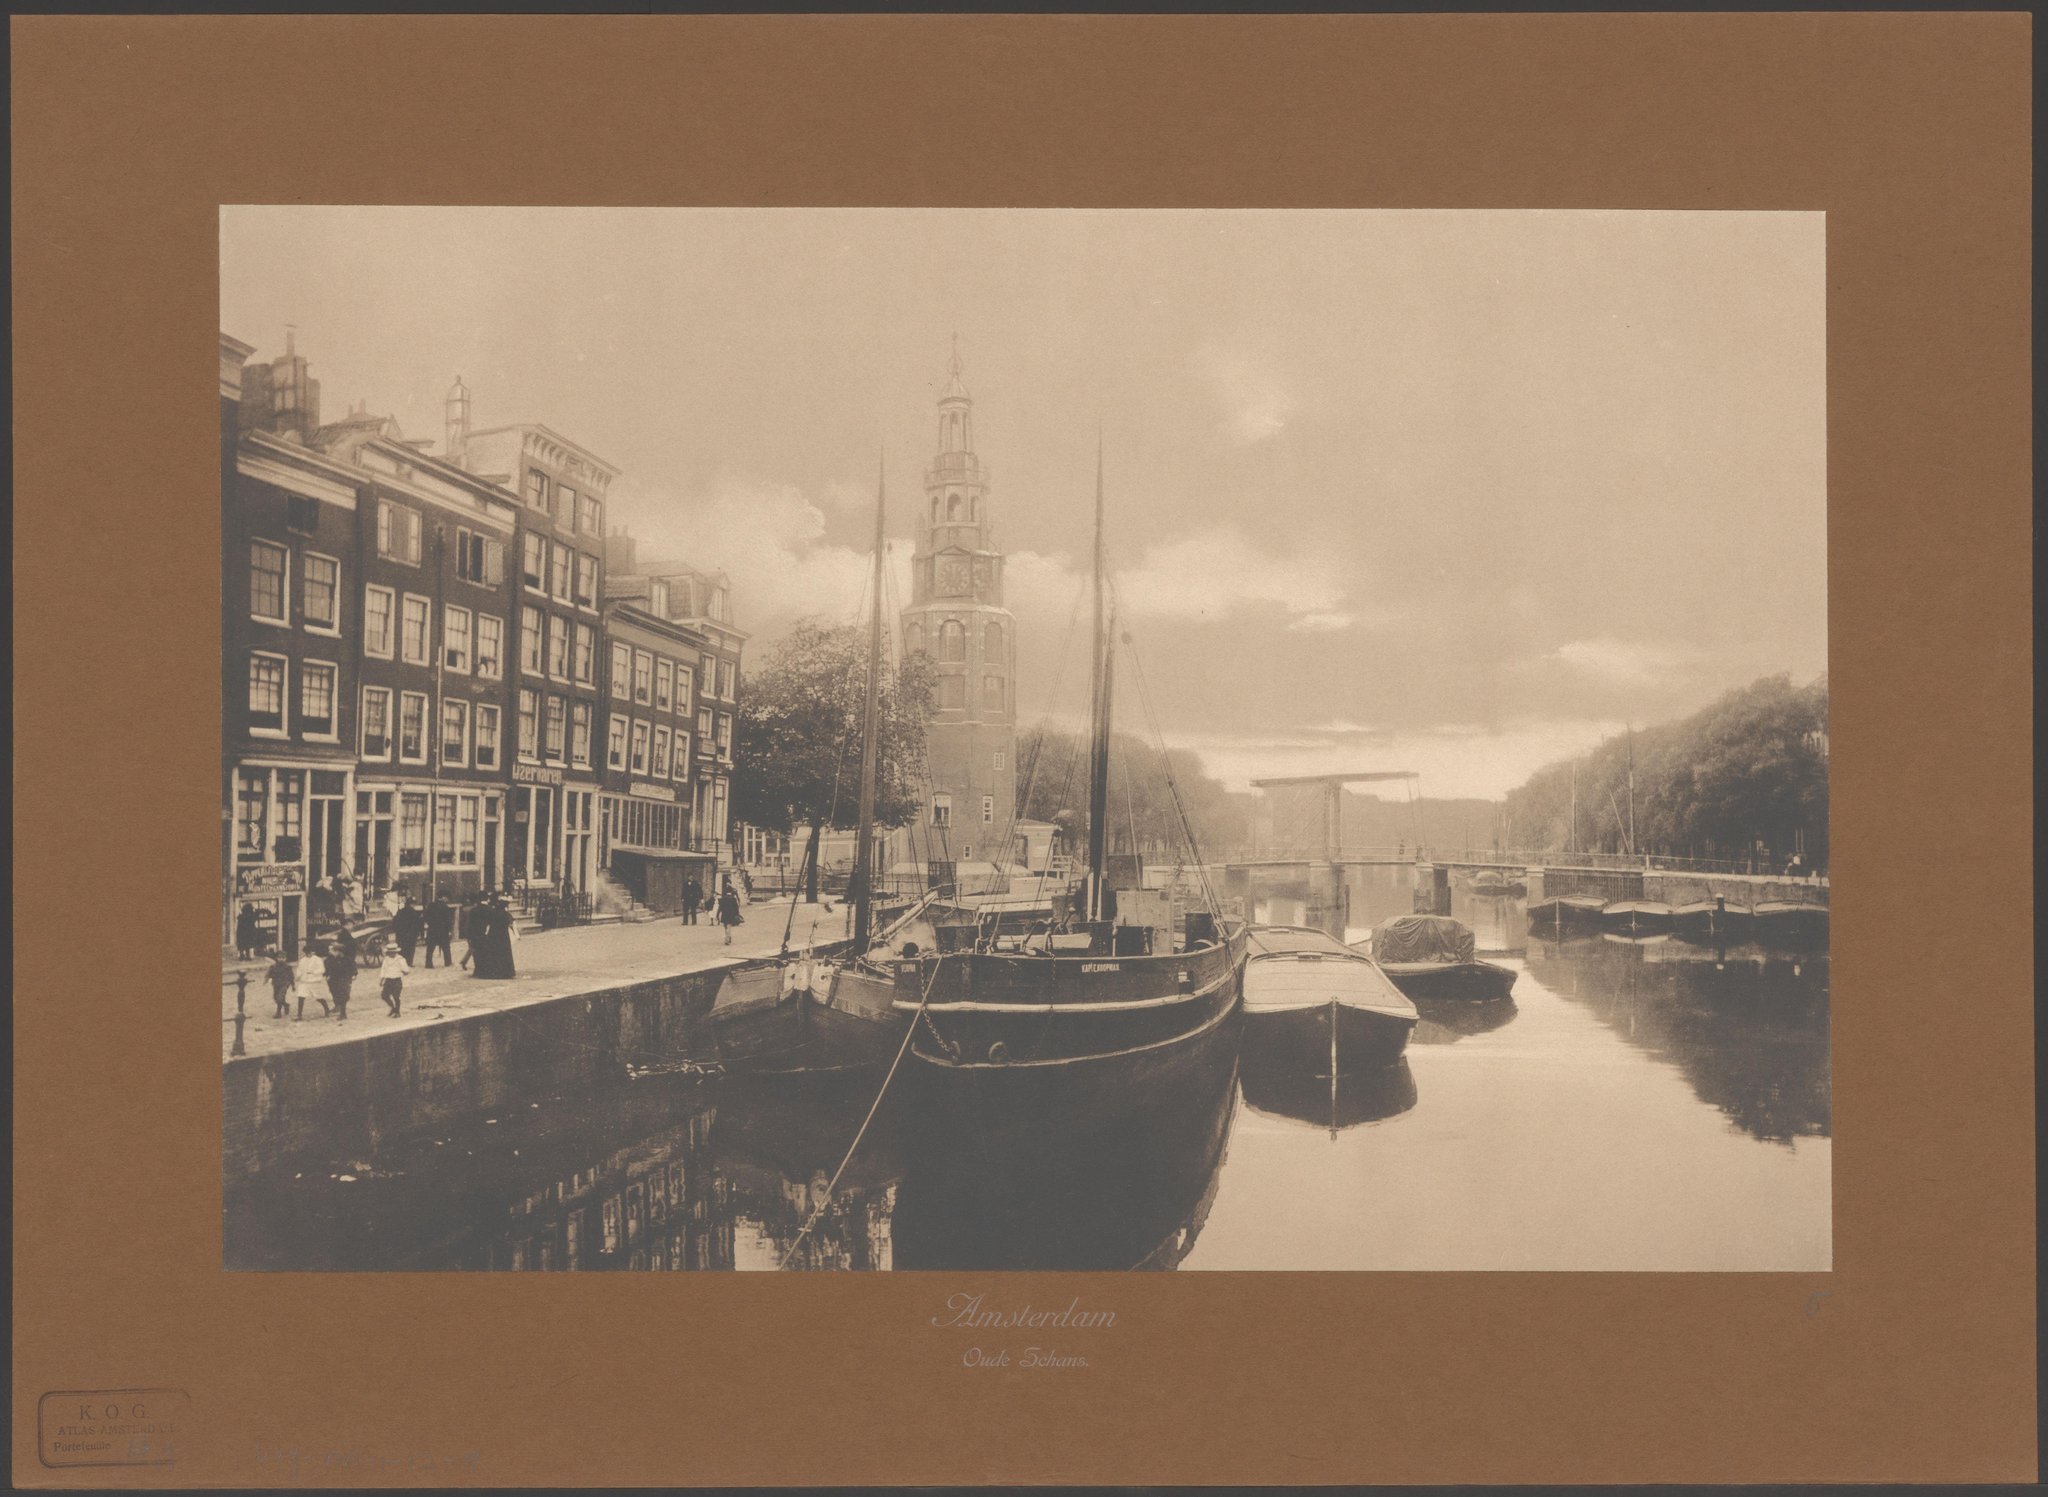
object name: photomechanical print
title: Gezicht op de Oudeschans en de Montelbaanstoren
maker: Anonymous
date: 1875-1930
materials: cardboard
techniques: photograph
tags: tower, clock tower ~ monumental adornment, city-view in general; 'veduta', river, tow-boat, towing-barge, bridge in city across river, canal, etc.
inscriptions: collector's mark: ‘13,9’ Lugt 1641b, inscription: ‘Amsterdam / Oude Schans’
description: Onderwerpsrubriek binnen de Atlas Amsterdam: Oude Schans, Schoutensteeg, Singel (Korte), Singel.